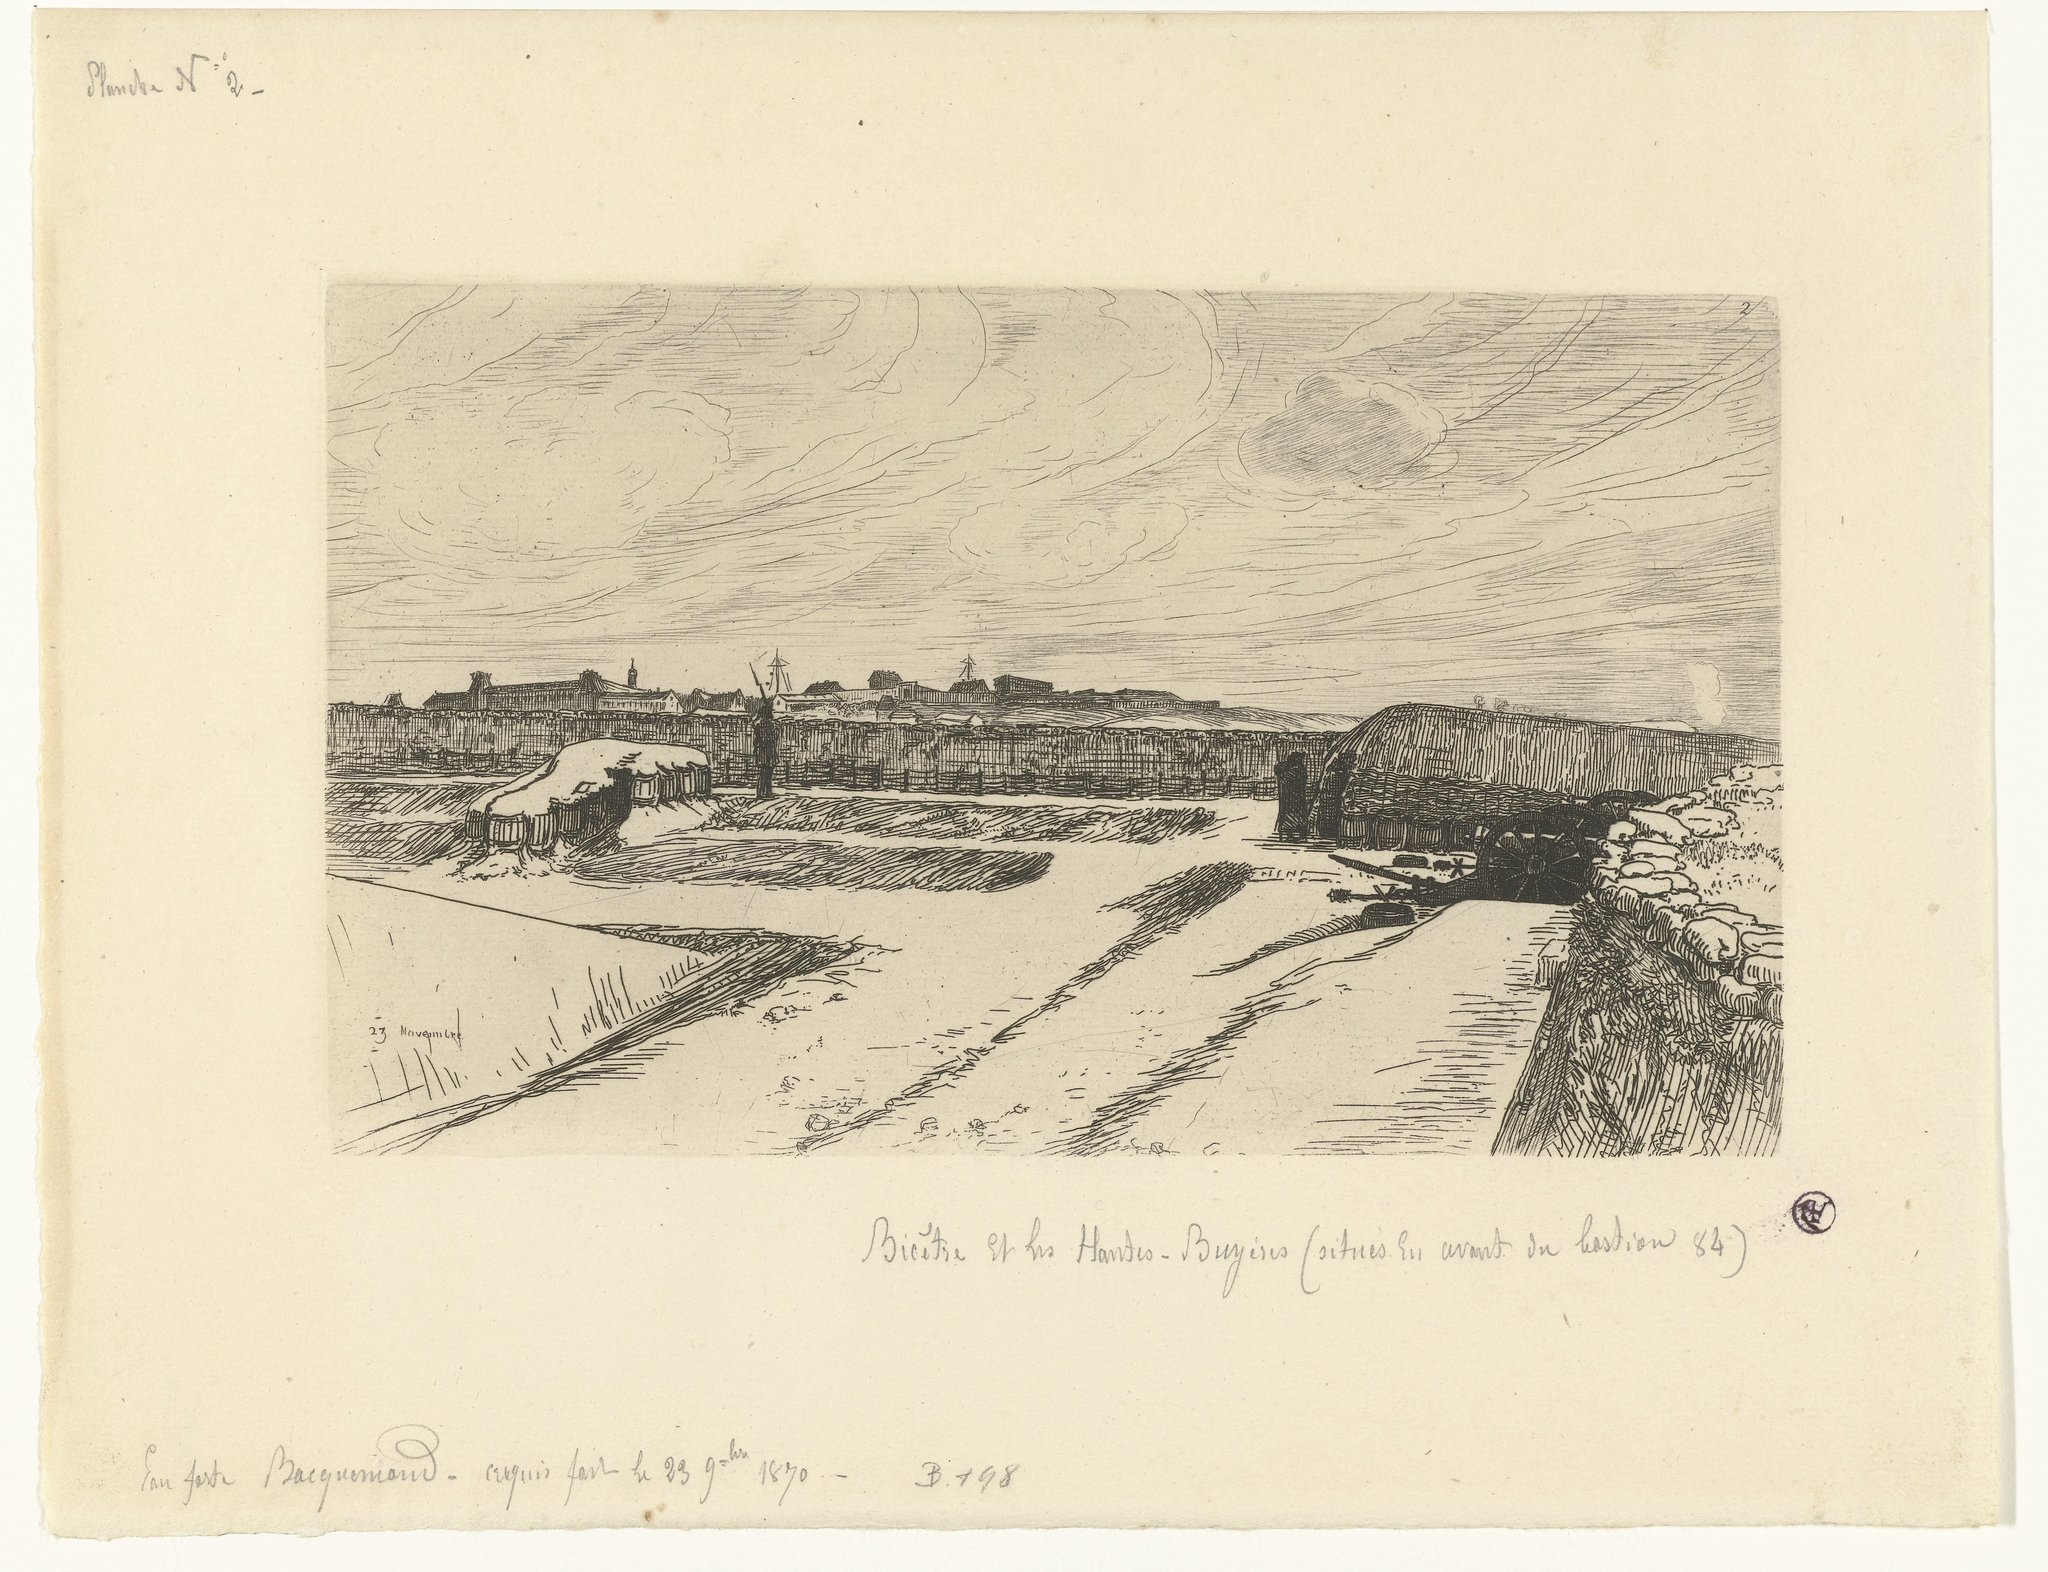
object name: print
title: Fort Bicêtre en schans Hautes-Bruyères voor het bastion 84 bij Parijs in de sneeuw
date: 1870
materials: paper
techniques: etching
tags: fortifications, military engineering, paris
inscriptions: collector's mark: Lugt 2228, collector's mark: Lugt 76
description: Het oude fort Bicêtre en de schans Hautes-Bruyères aan de zuidkant van Parijs, gelegen voor het bastion 84. De datum 23 november verwijst naar de schets die de kunstenaar maakte op de winterse dag met sneeuw en later gebruikte als voorstudie voor deze voorstelling op de etsplaat.